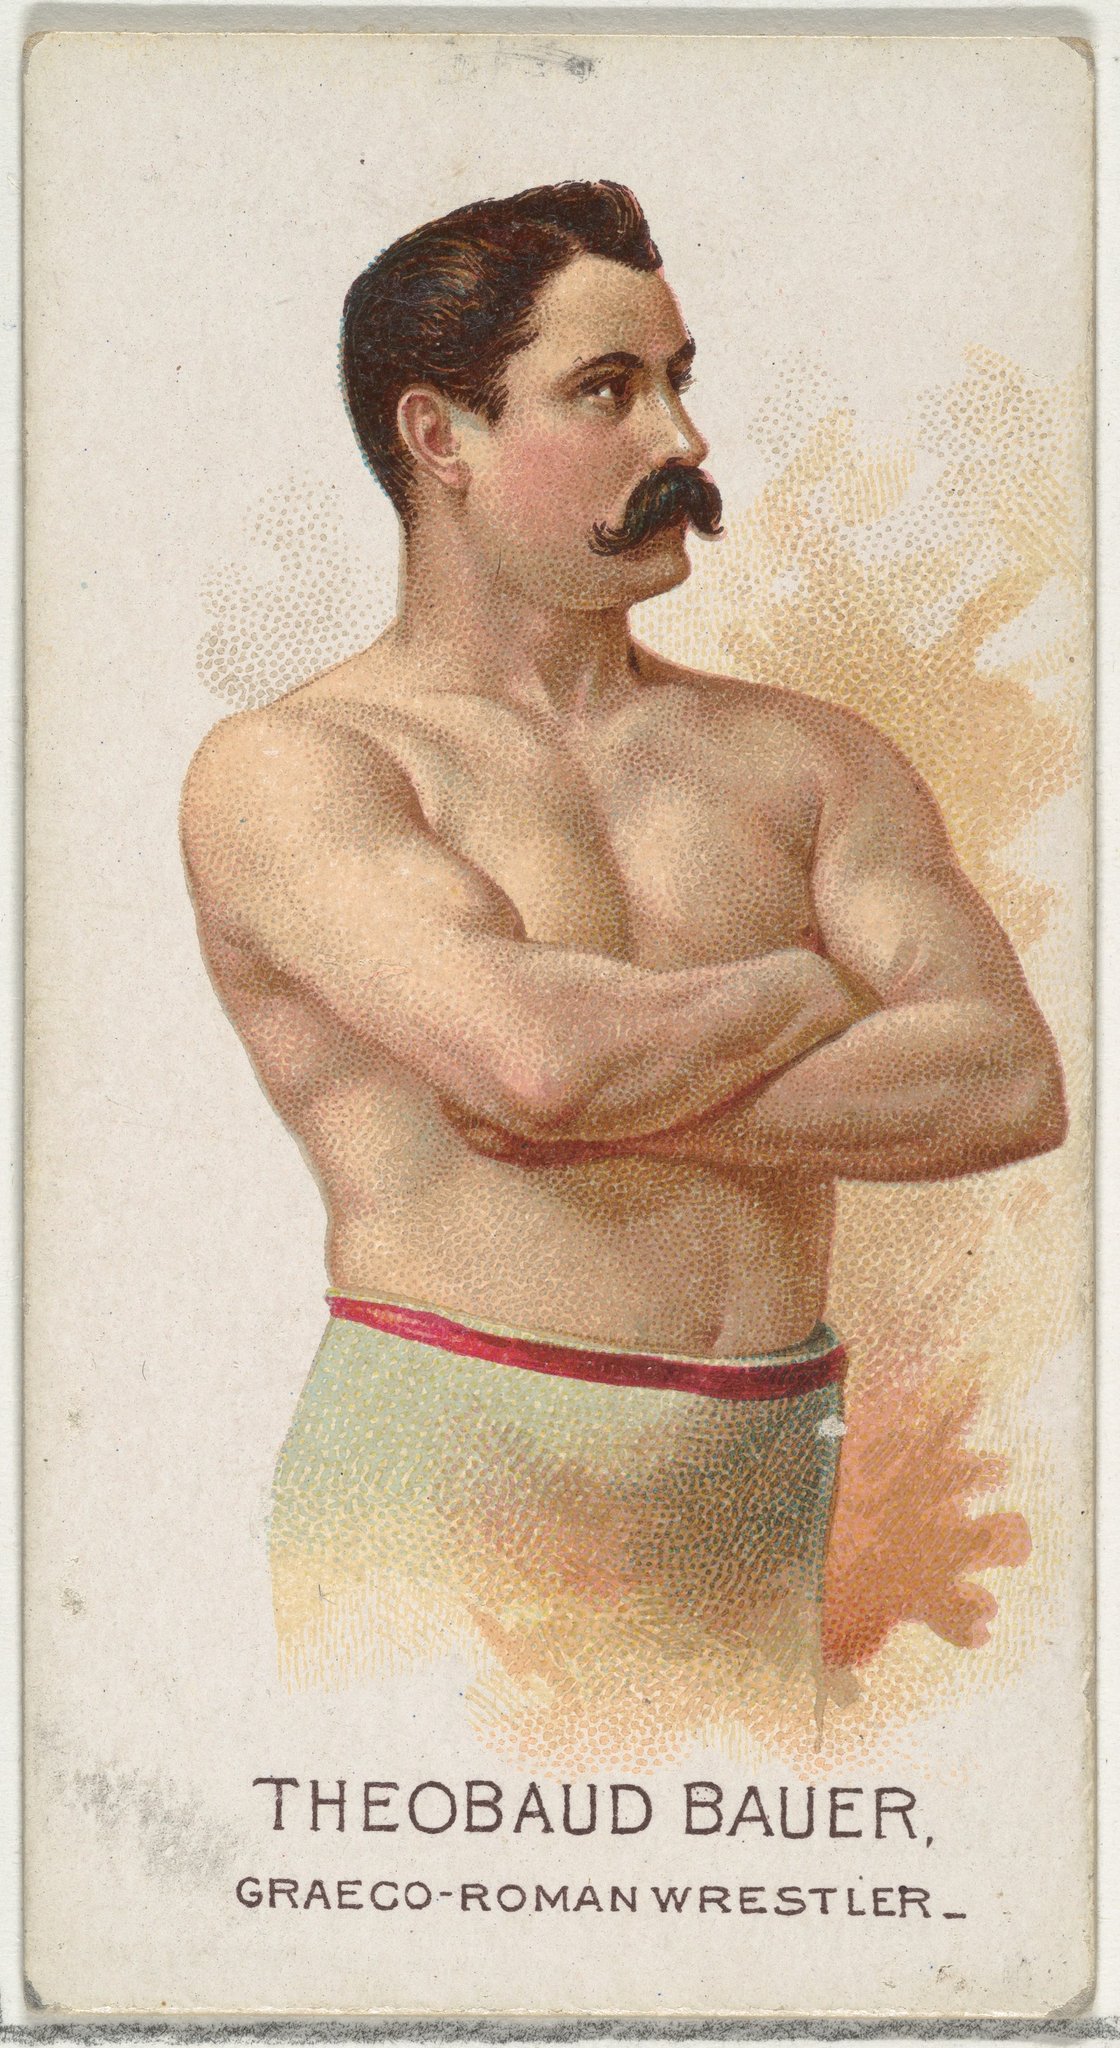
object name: print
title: Theobaud Bauer, Greco-Roman Wrestler, from World's Champions, Series 2 (N29) for Allen & Ginter Cigarettes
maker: allen & ginter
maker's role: publisher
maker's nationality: american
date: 1888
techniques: color lithograph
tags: men,portraits